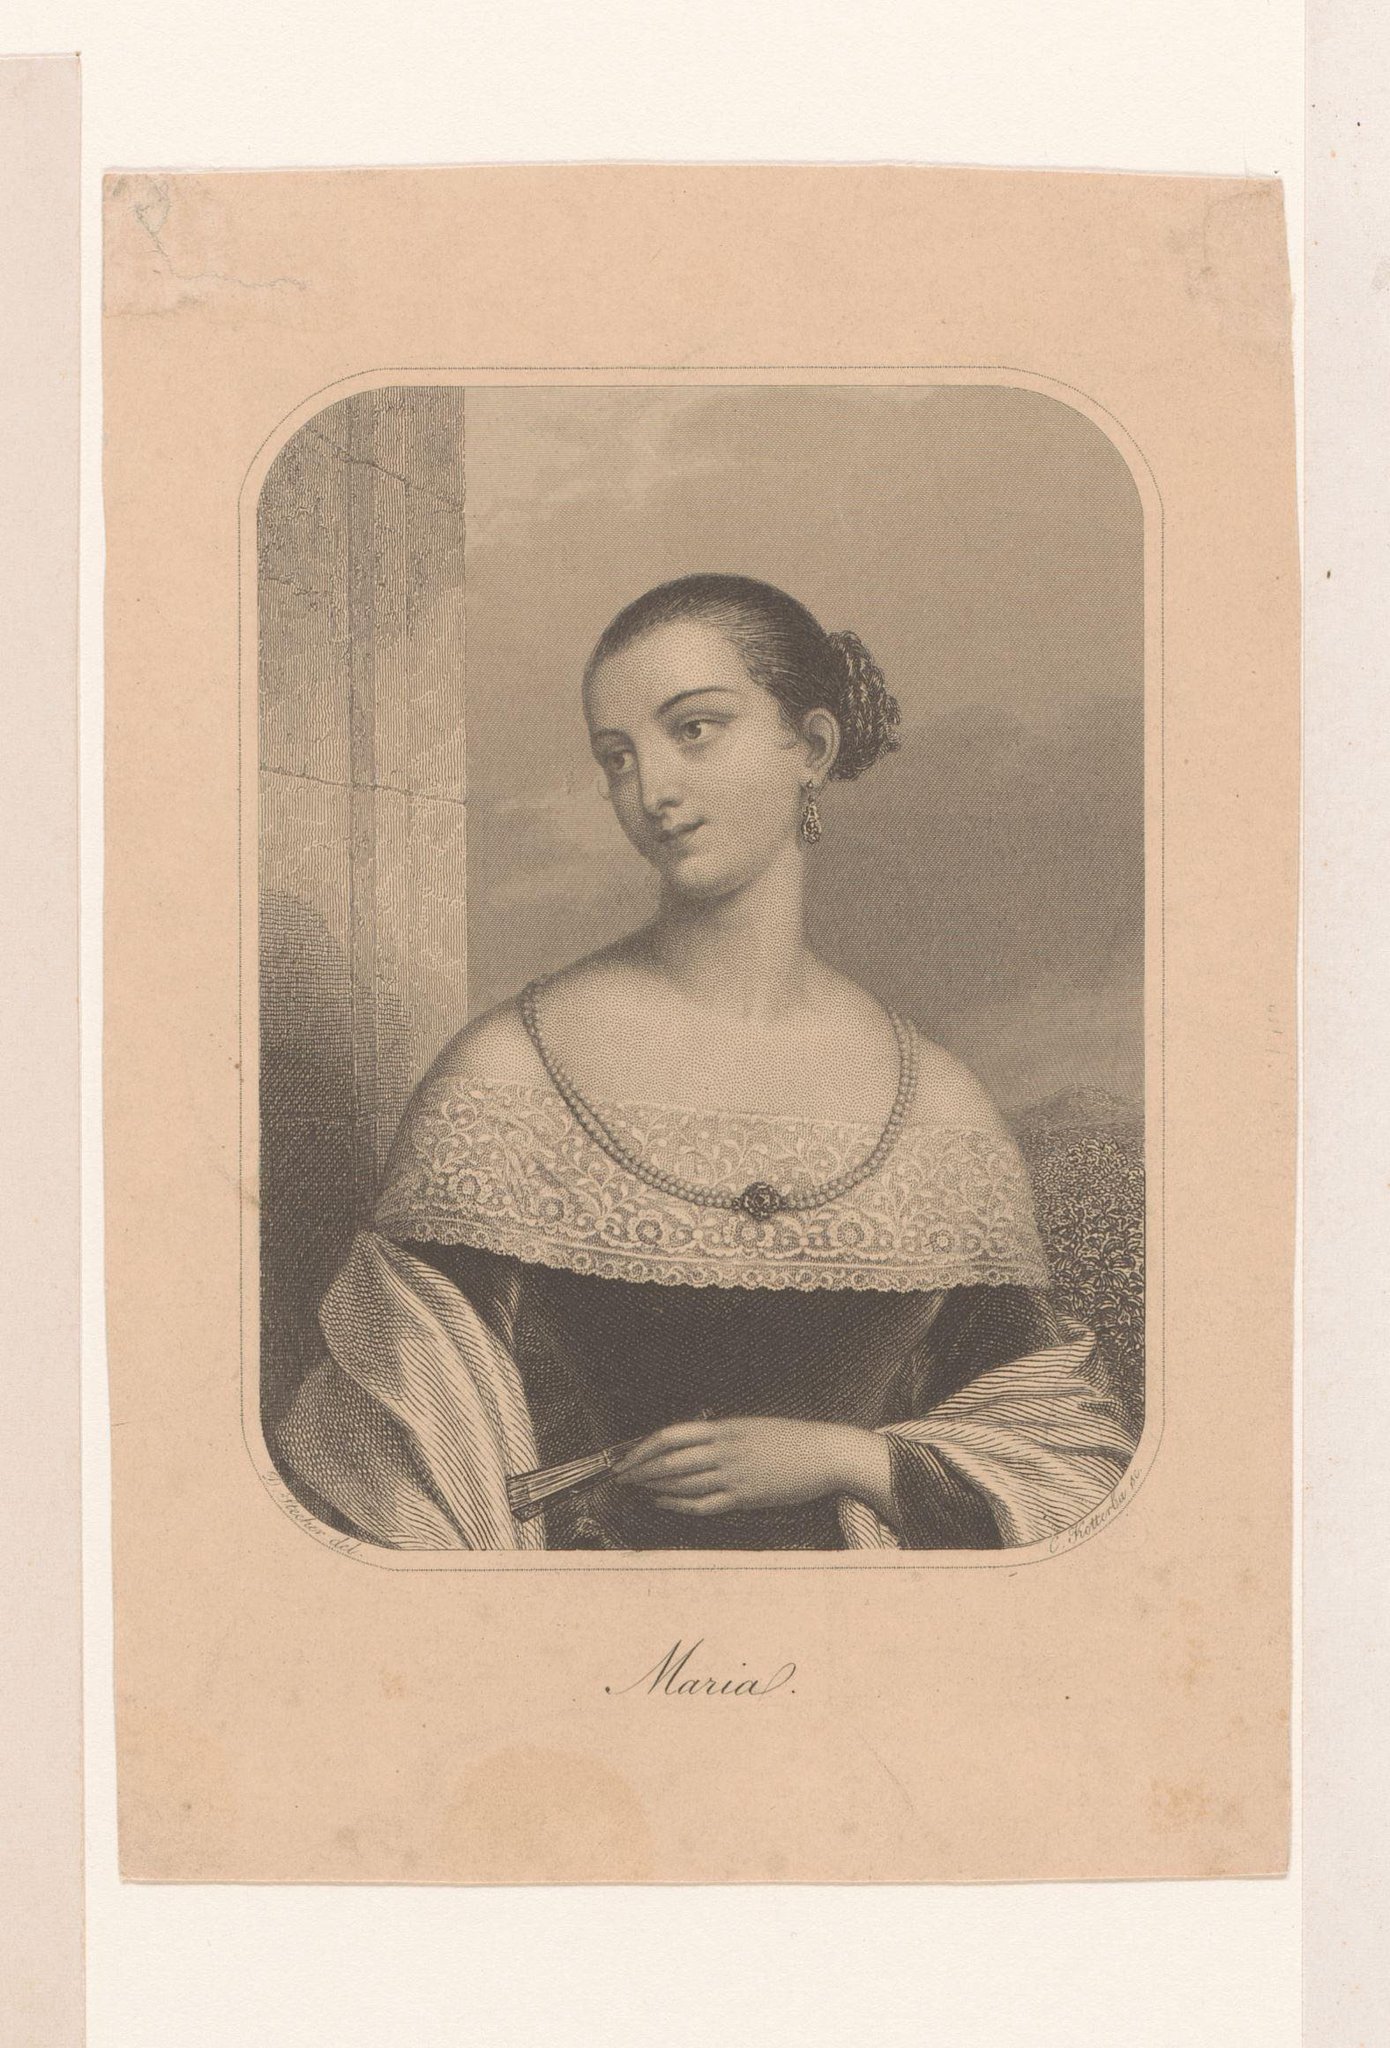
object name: print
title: Portret van een onbekende vrouw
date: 1810-1859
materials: paper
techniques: engraving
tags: anonymous historical person portrayed alone - bb - woman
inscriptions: collector's mark: Lugt 2228